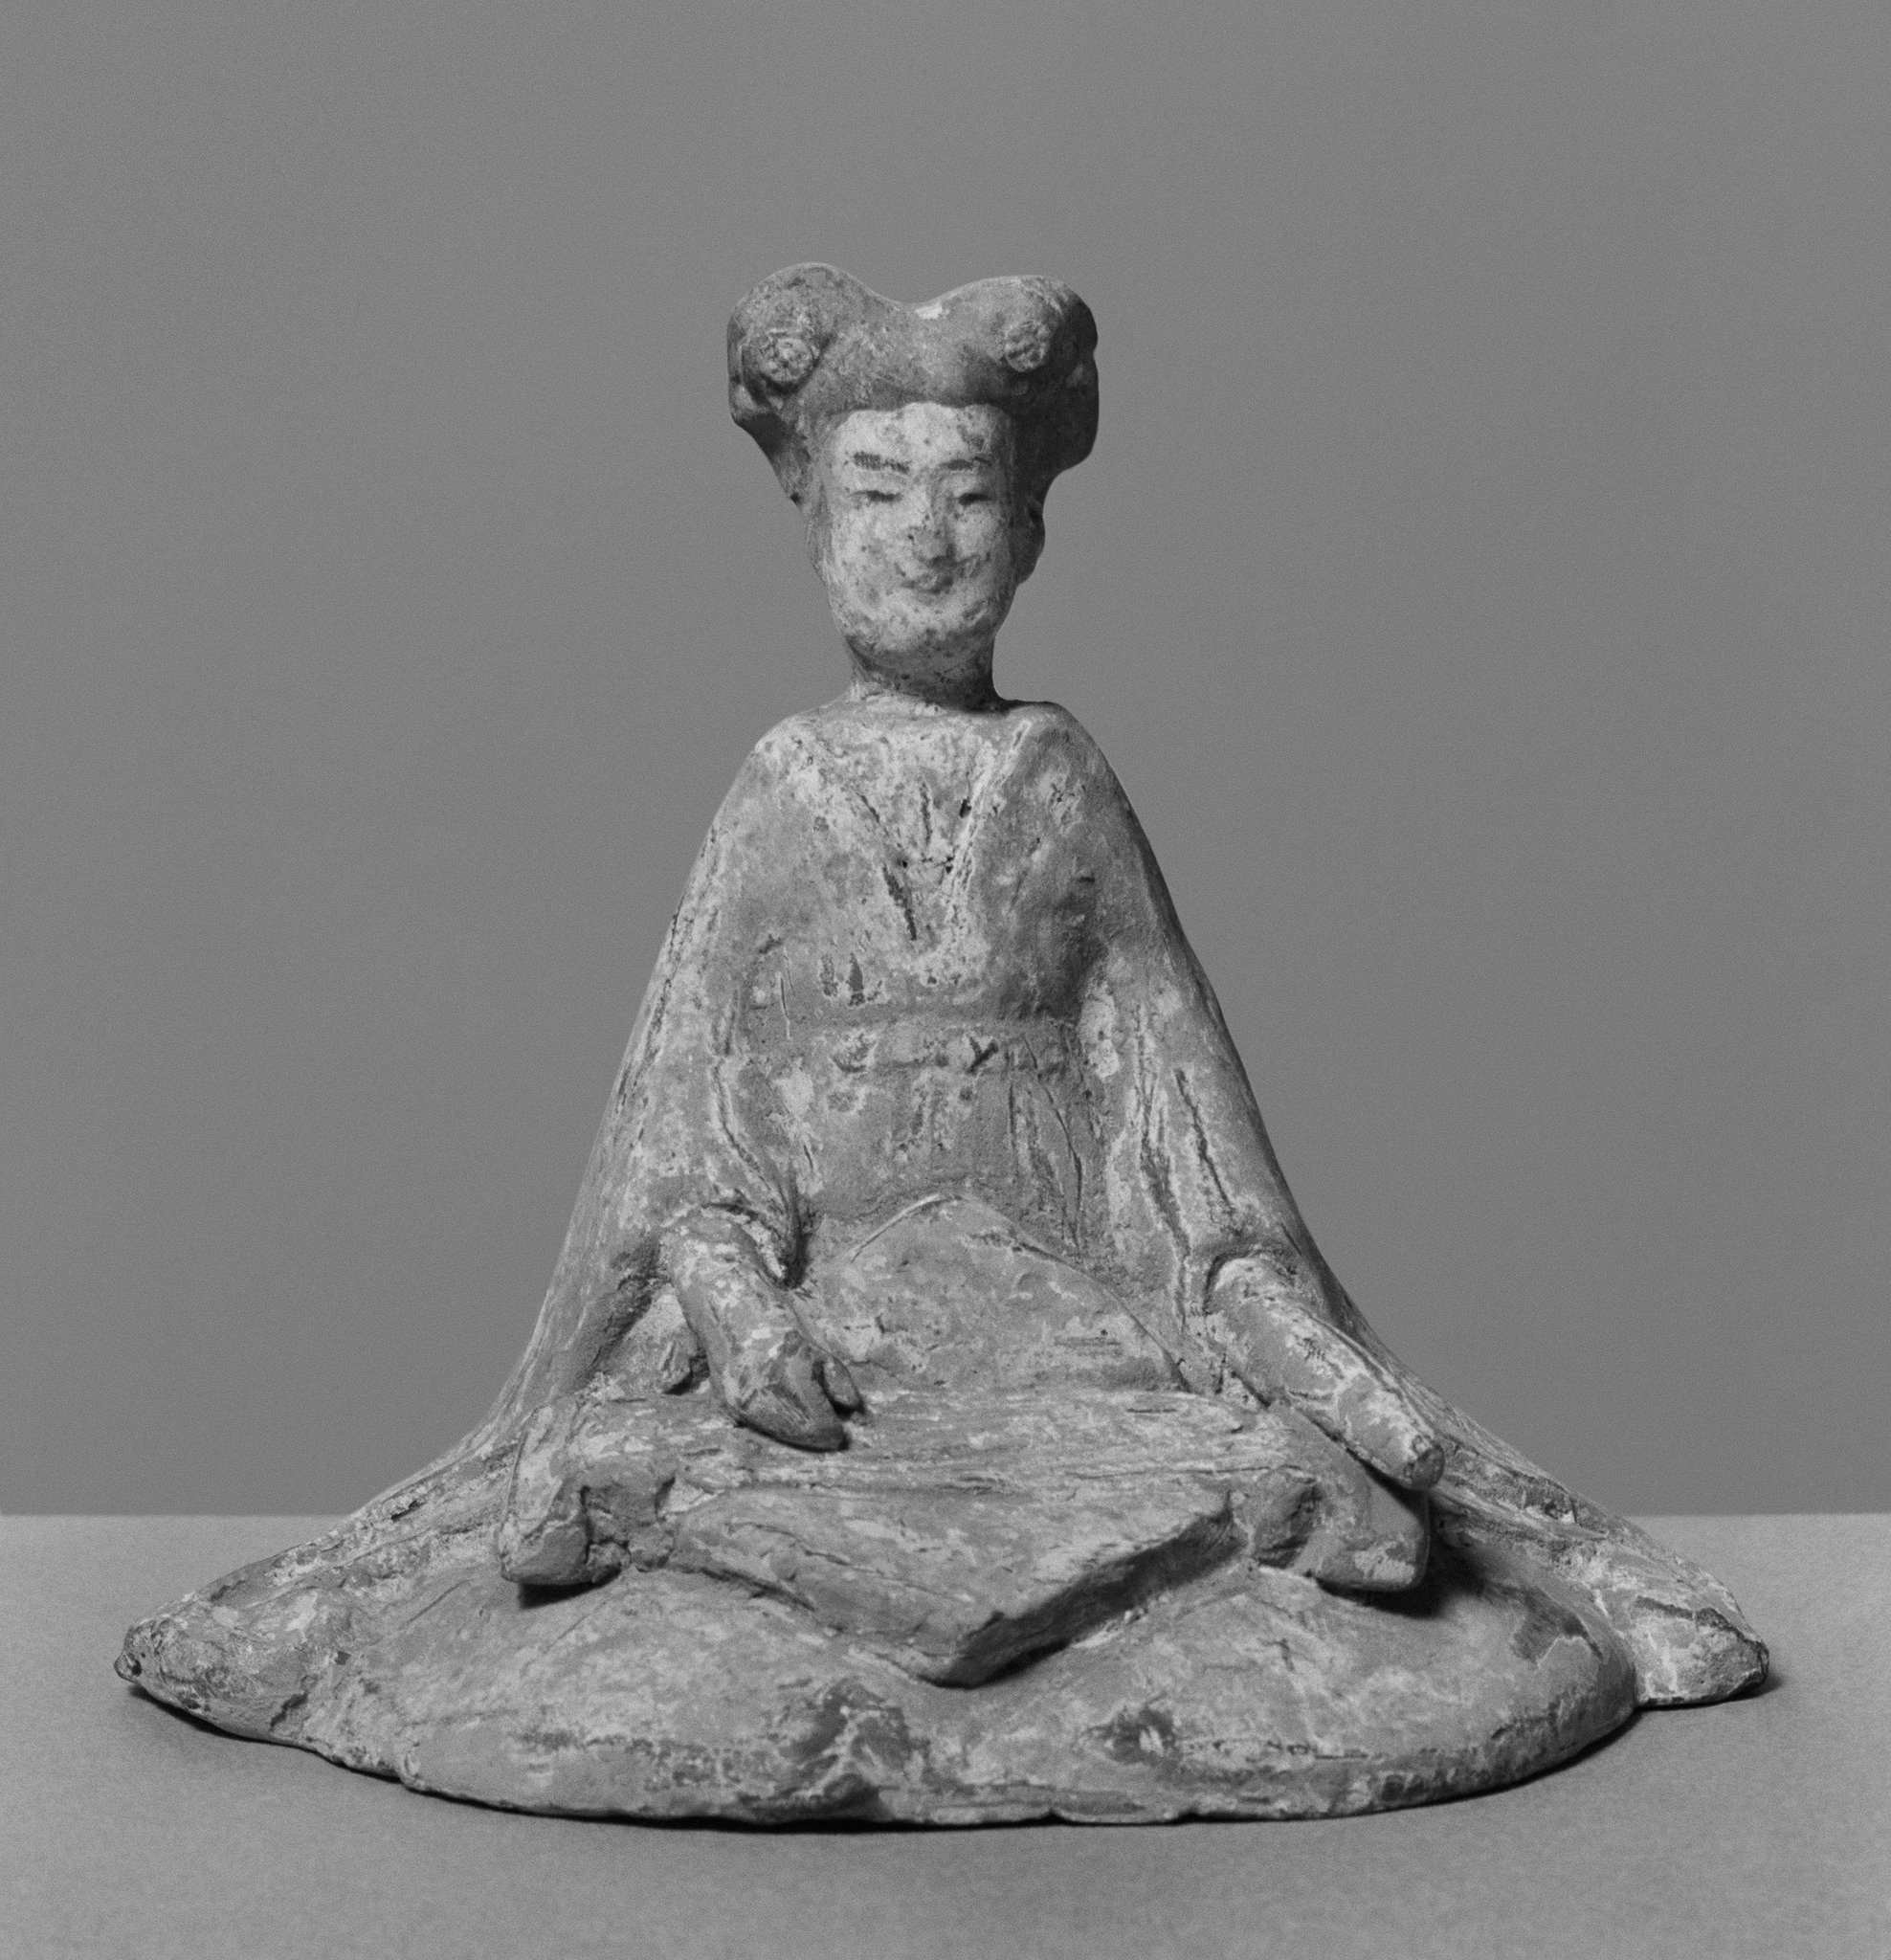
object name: figure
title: Female musician with zither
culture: chinese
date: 501-700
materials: earthenware, pigment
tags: musicians